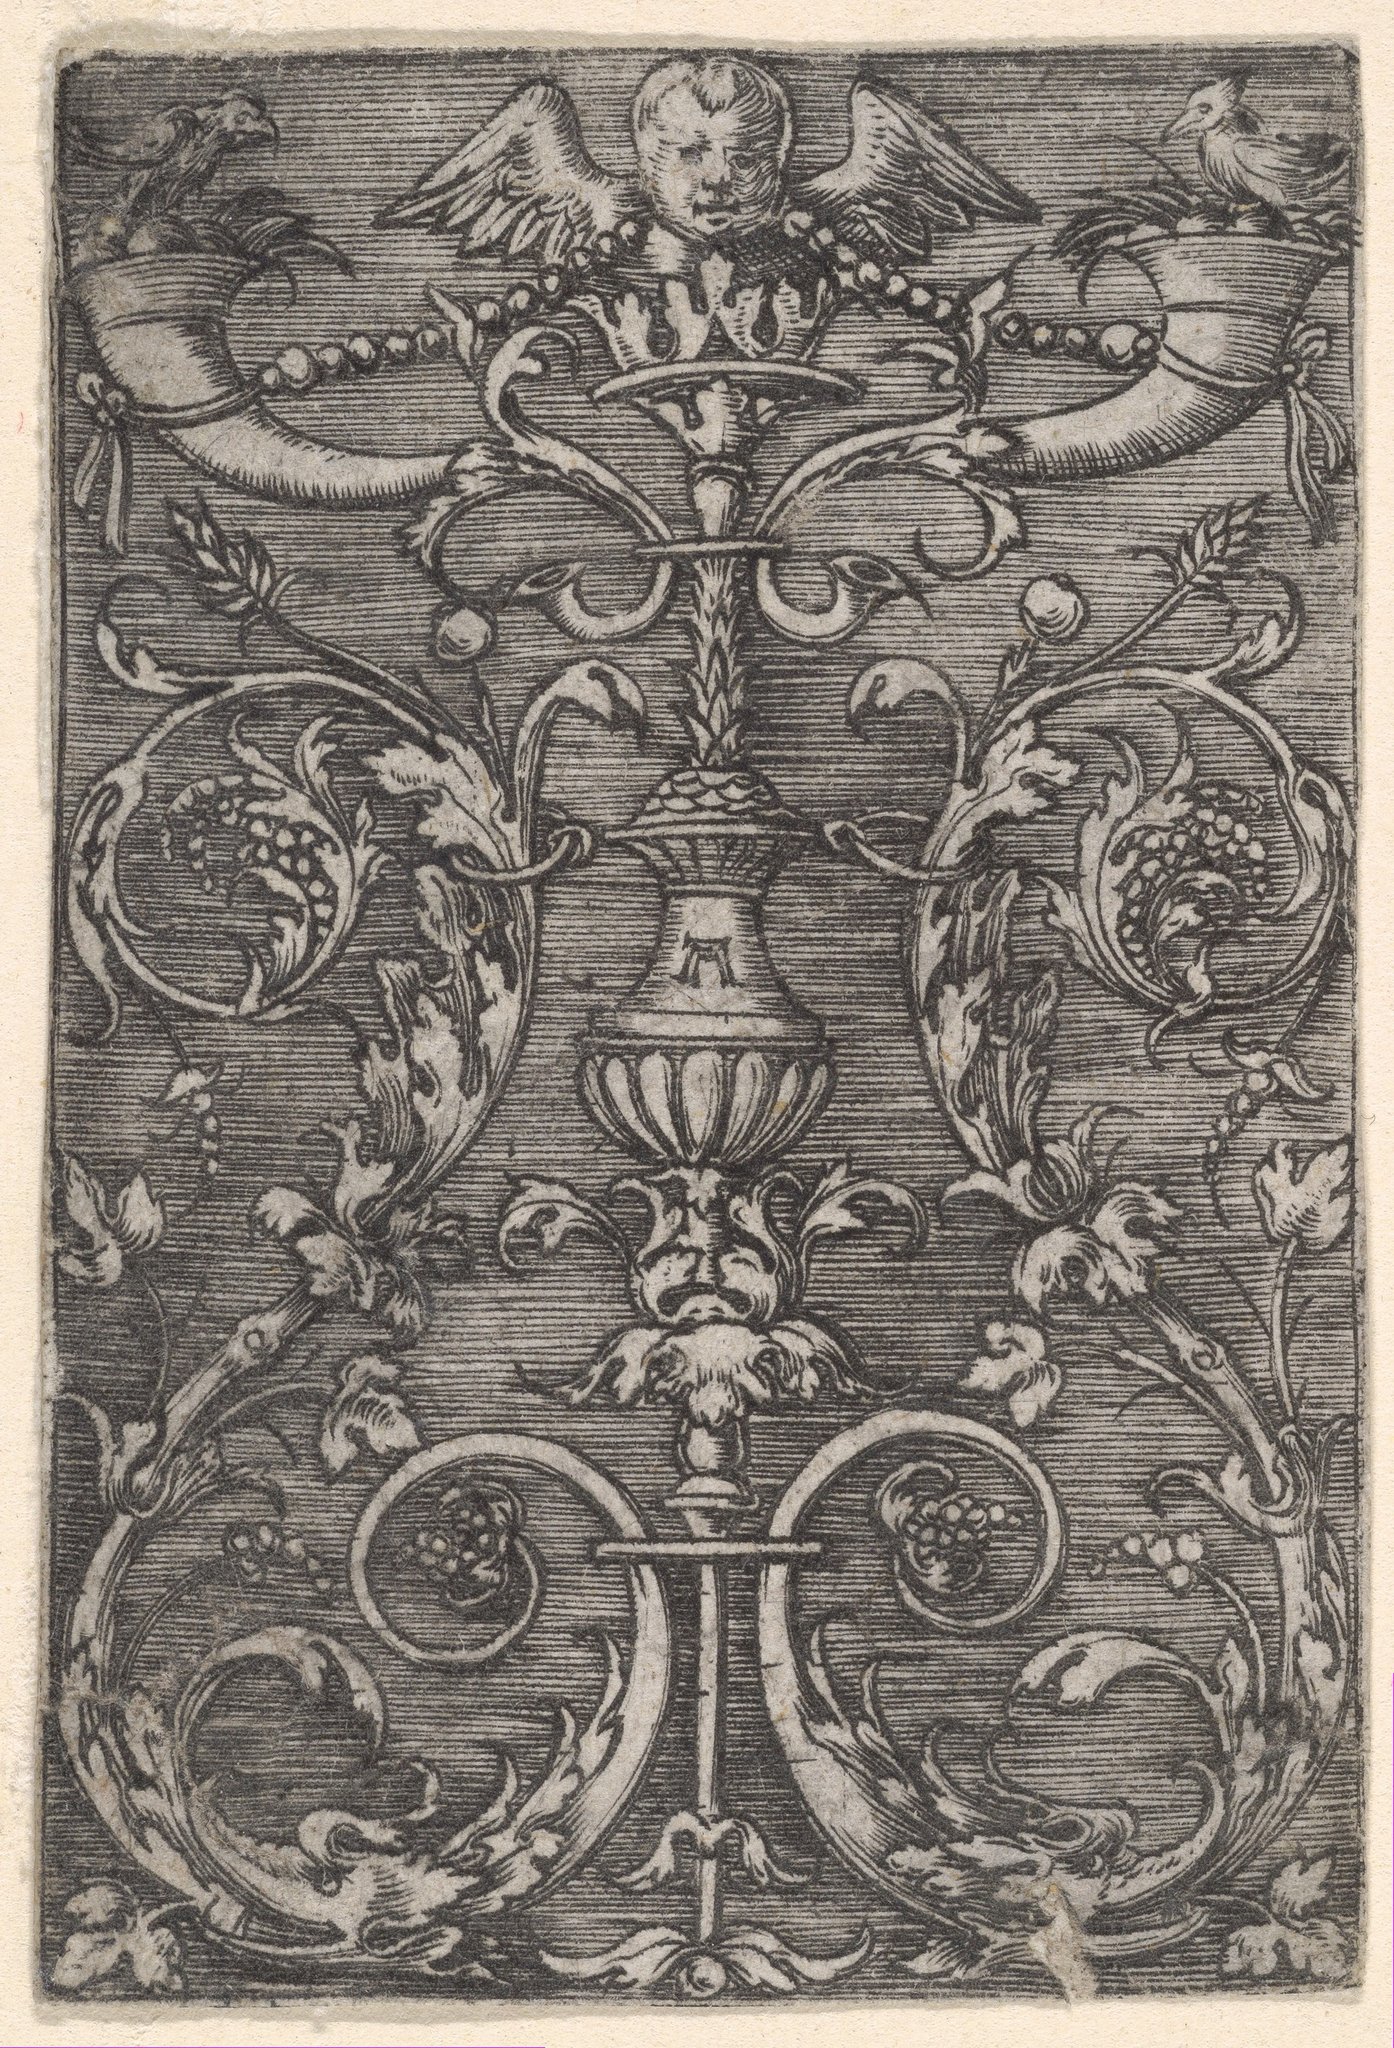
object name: print ornament architecture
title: Ornamental Design with an Angels Head at Top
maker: albrecht altdorfer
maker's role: artist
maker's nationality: german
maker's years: 1480-1538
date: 1500-1538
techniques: engraving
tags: birds,ornament,cornucopia,angels